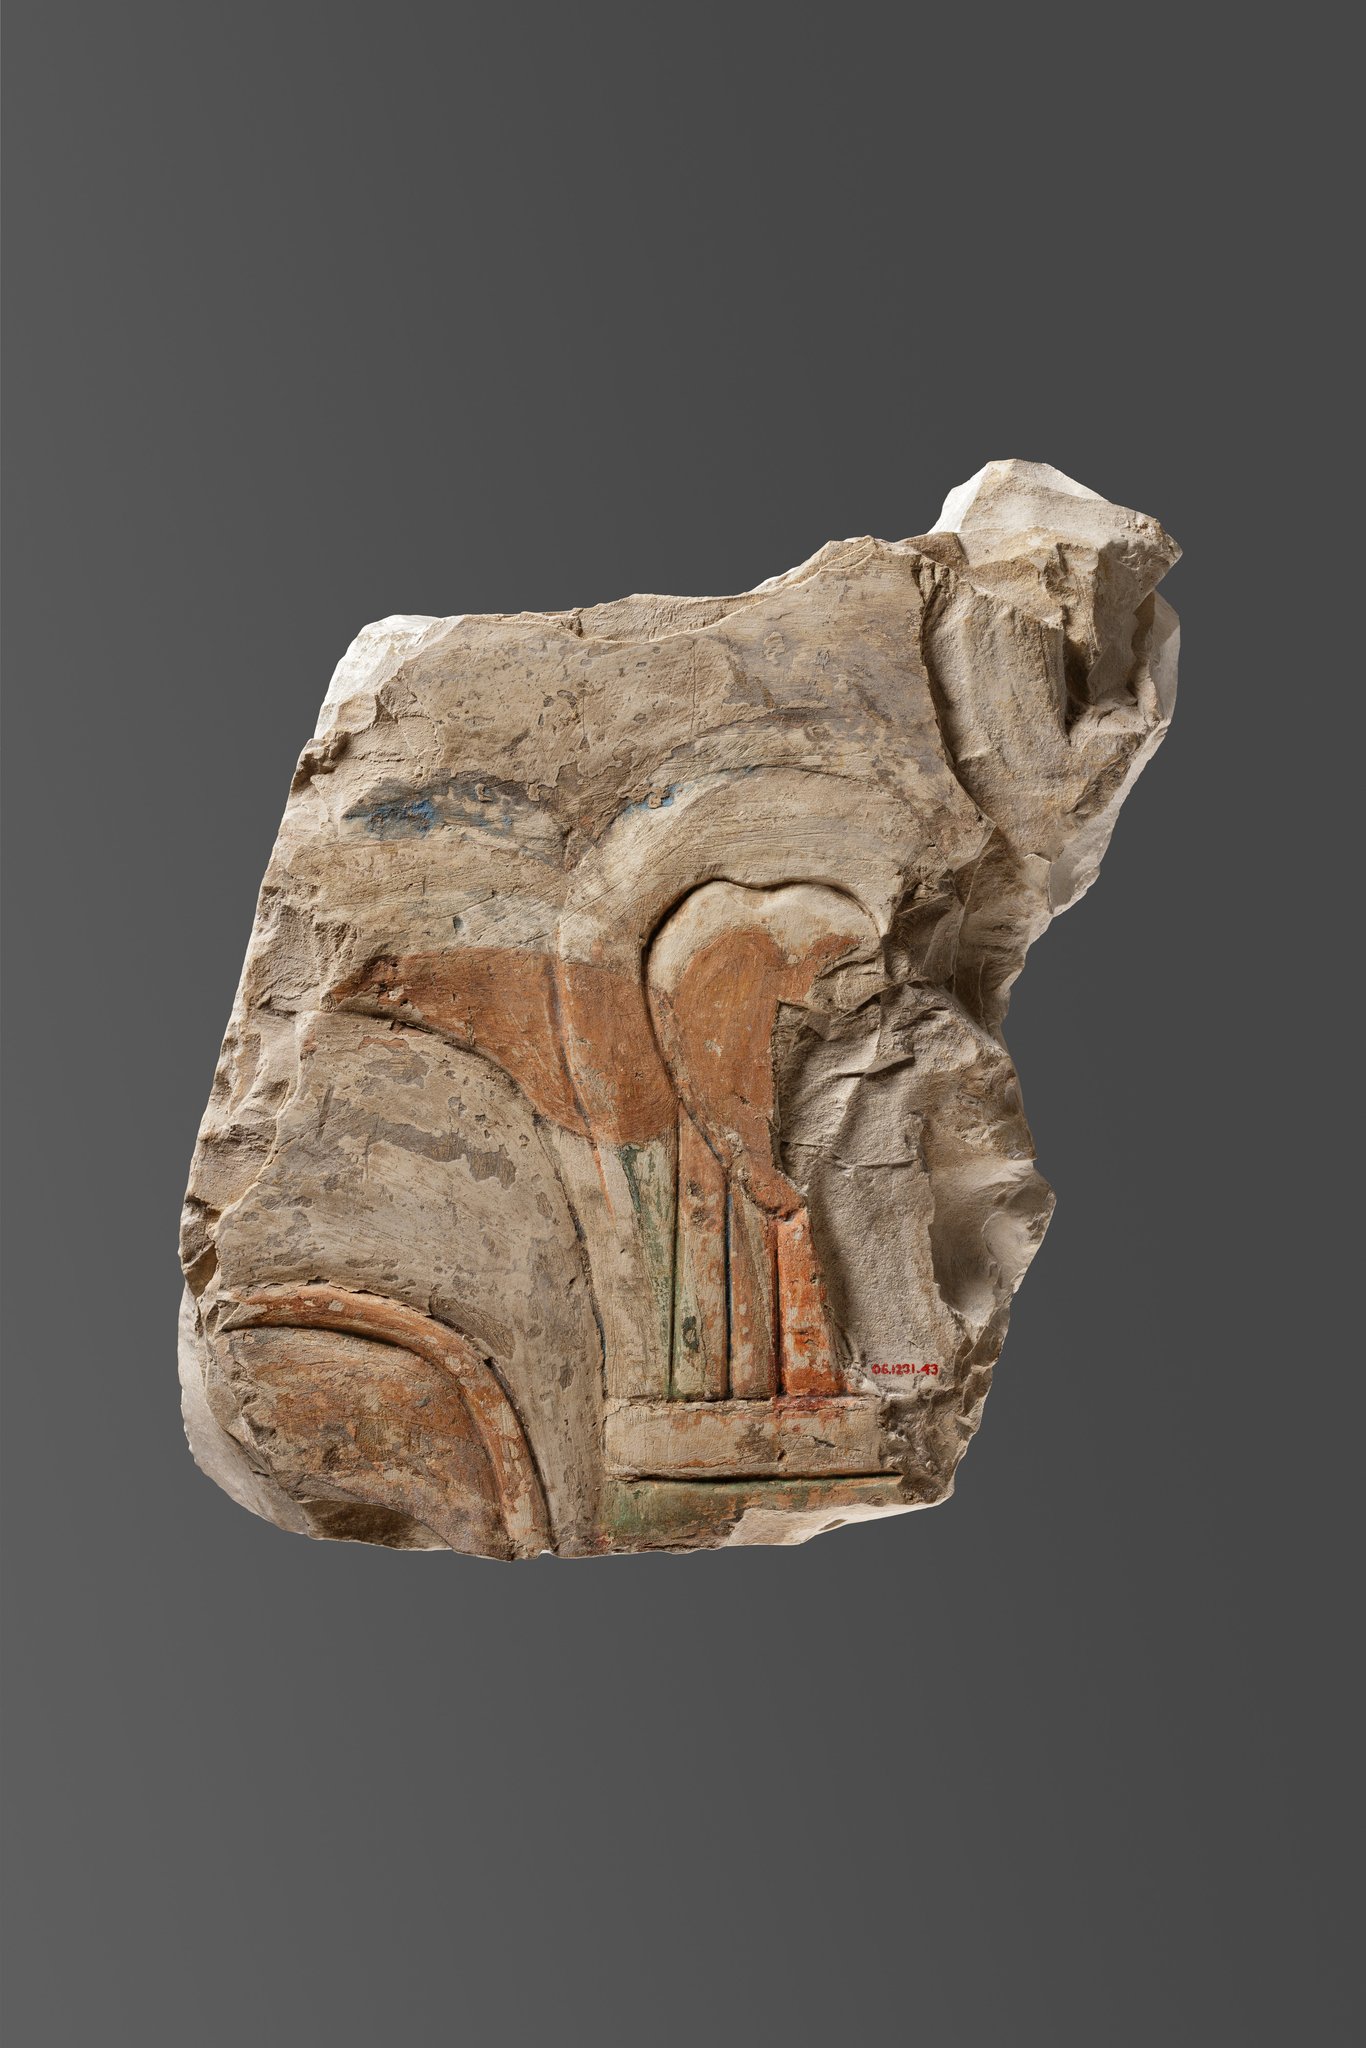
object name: tile, palmette ornament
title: Palmette-like ornament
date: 2030-1640 BCE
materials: limestone, paint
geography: egypt